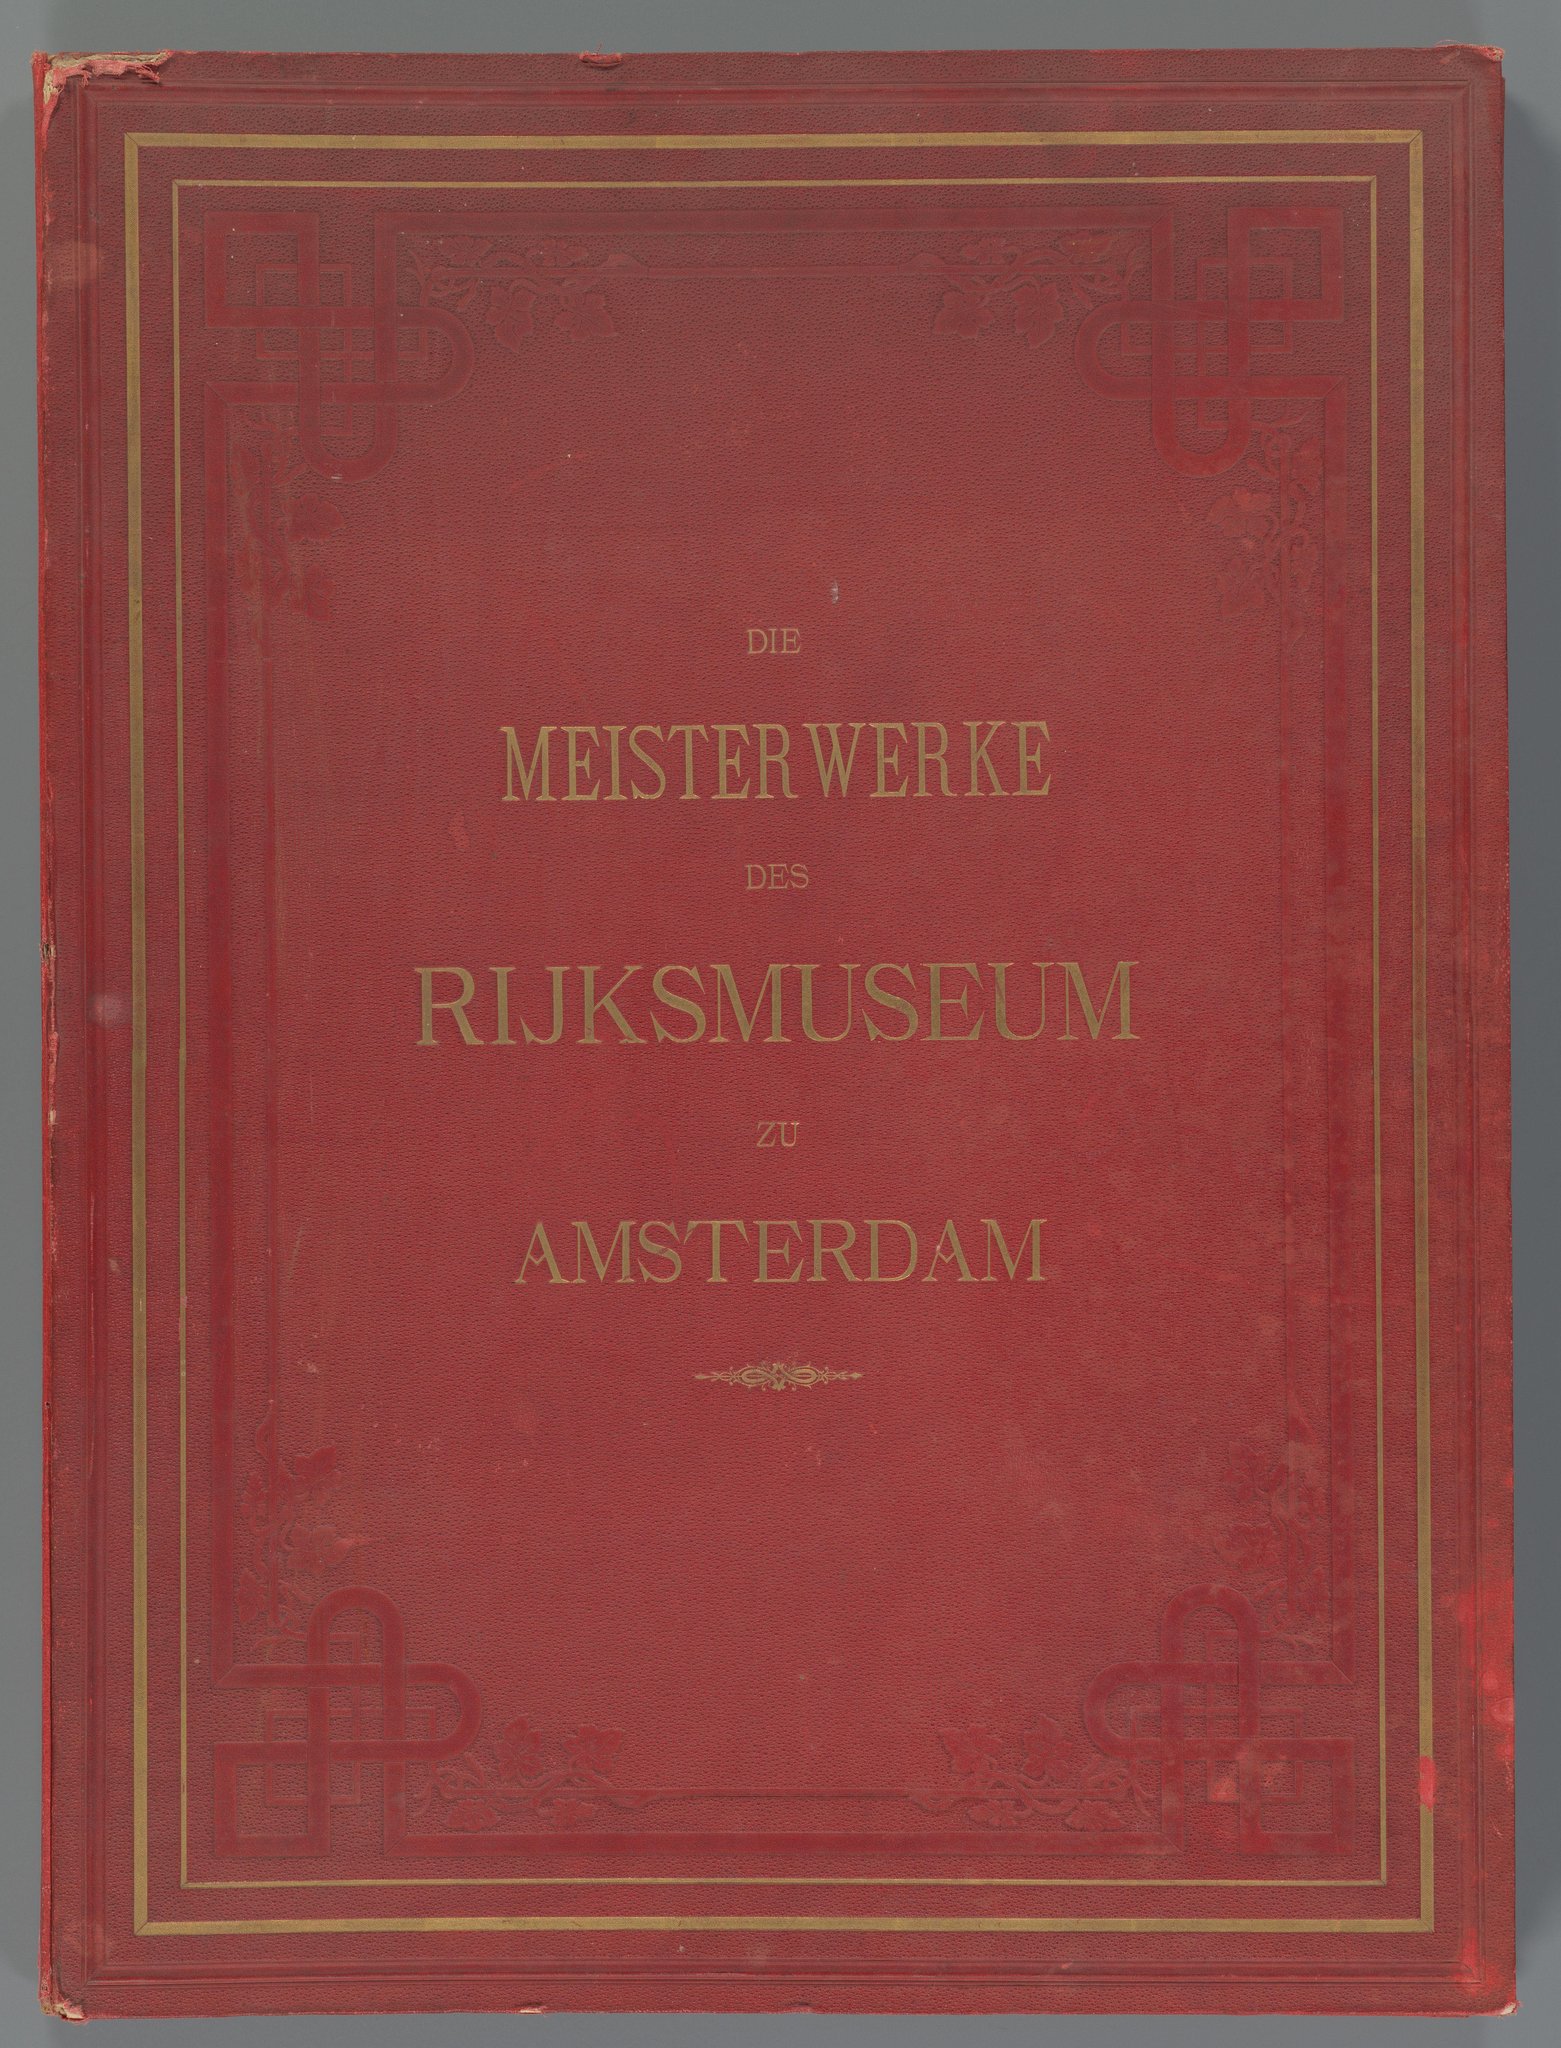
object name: wrapper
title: Die Meisterwerke des Rijksmuseum zu Amsterdam. Nach dem Original-Gemälden photographirt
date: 1885-1887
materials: cardboard, linen, paper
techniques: carbon print, letterpress printing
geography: munich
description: Omslag voor negen fotoreproducties en een tekstblad.